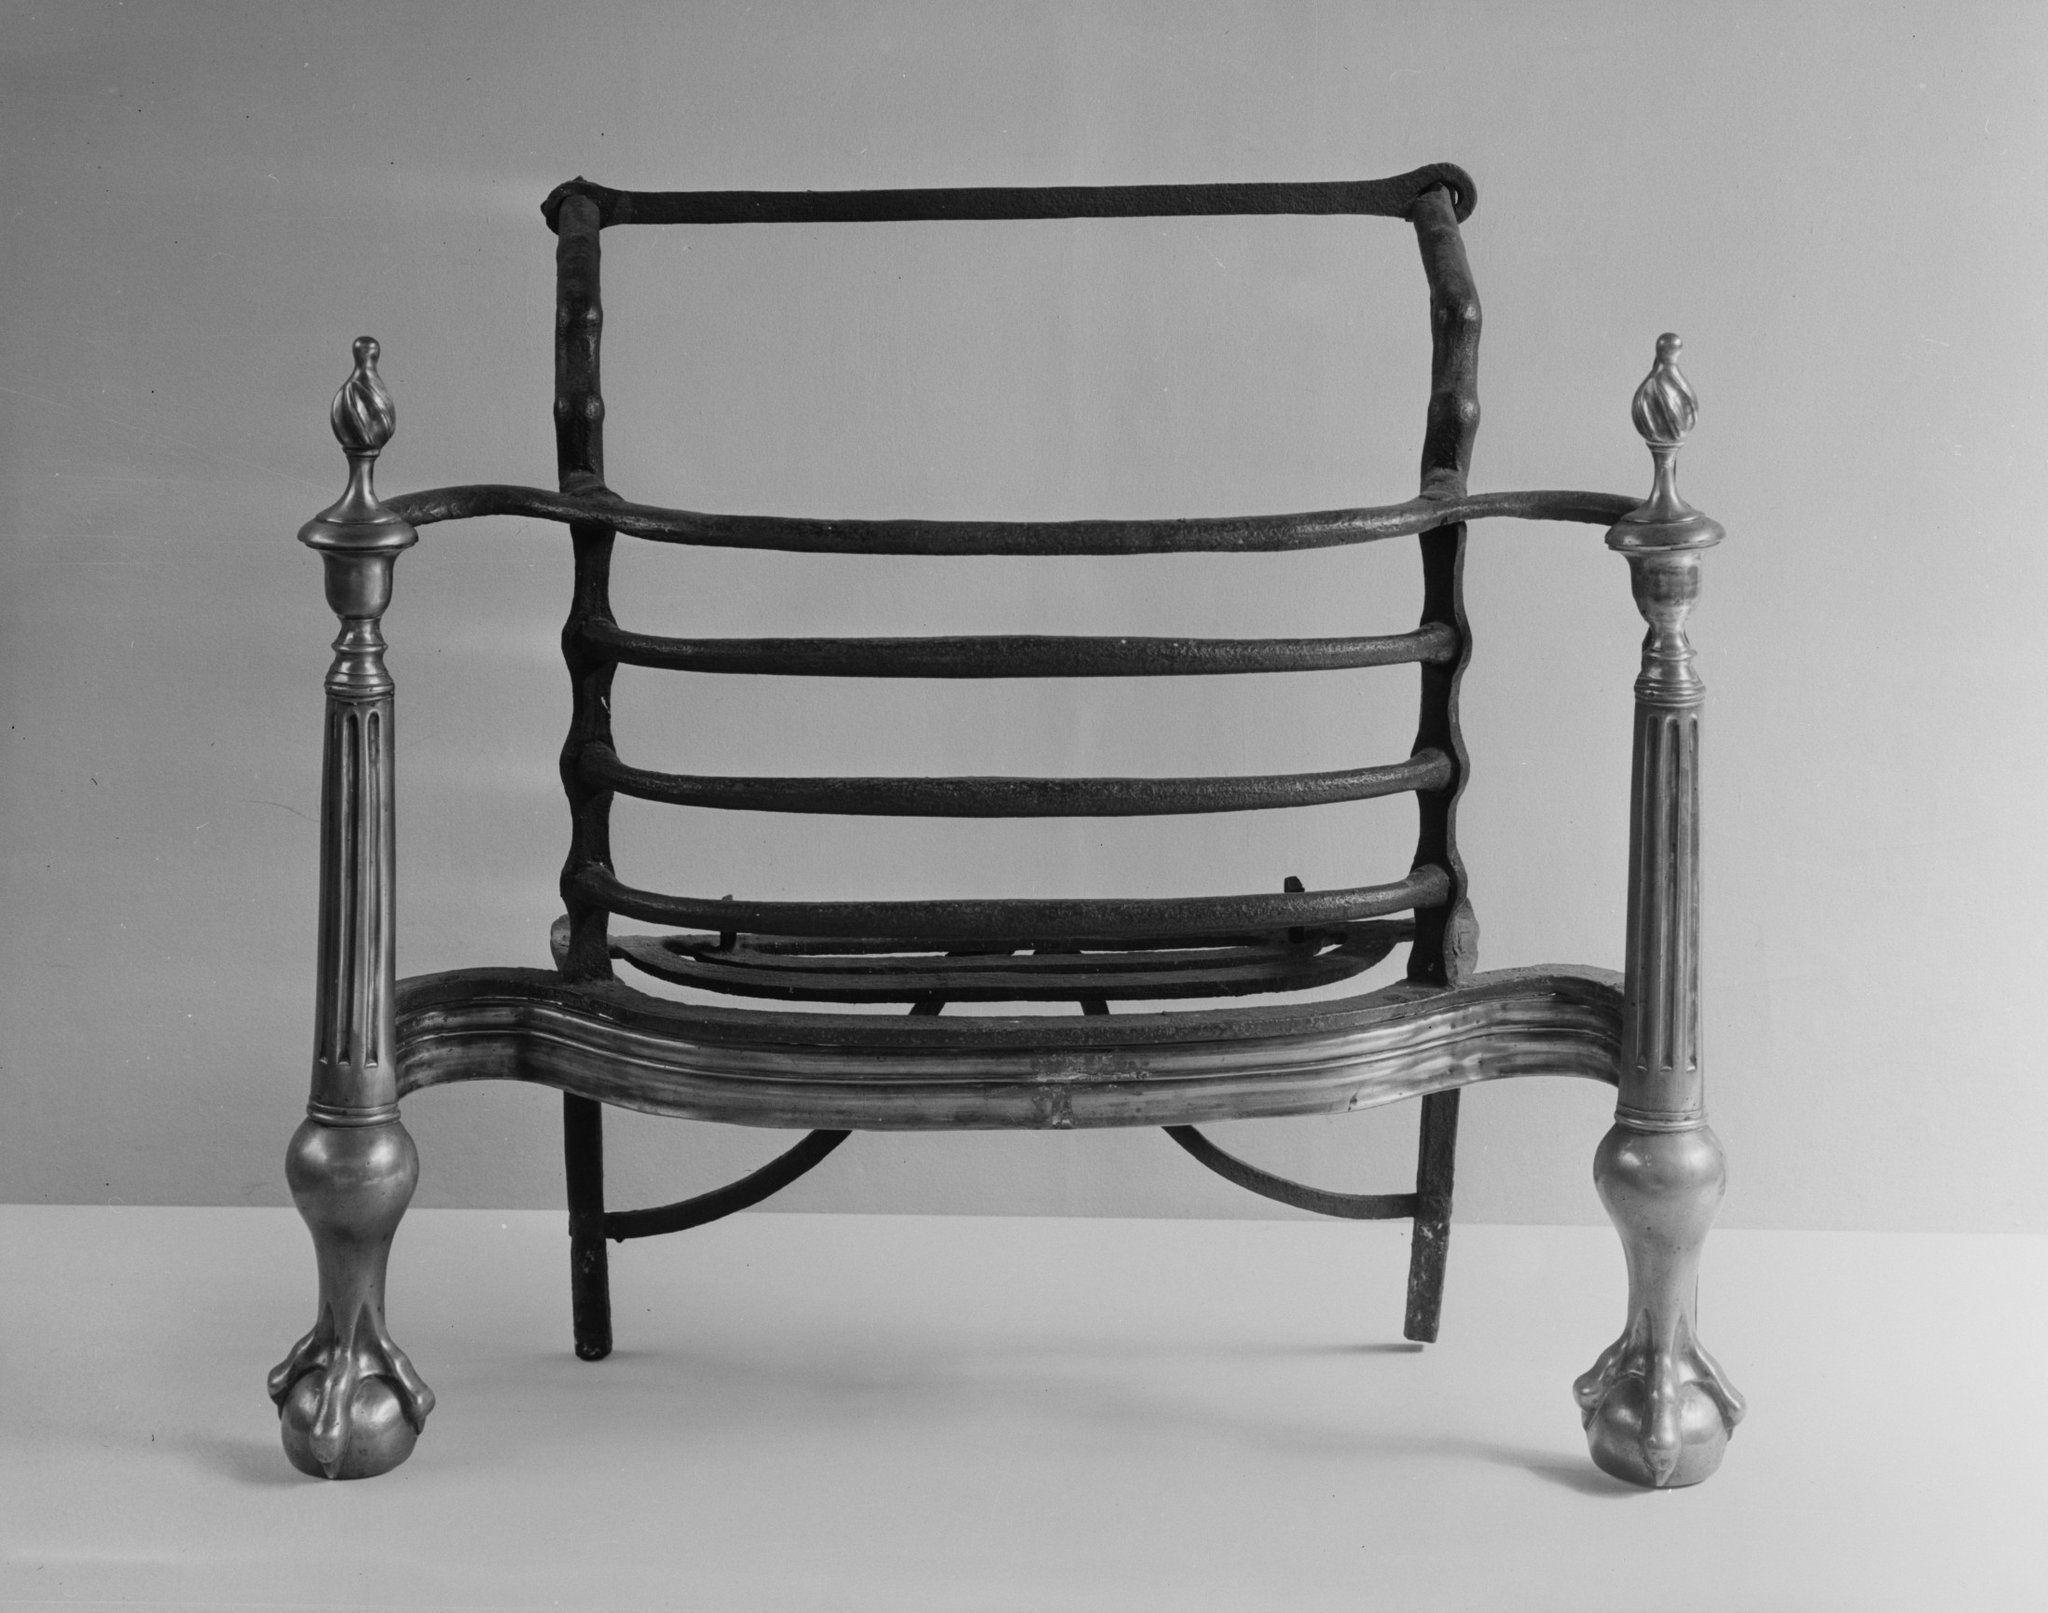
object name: grate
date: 1760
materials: brass, iron